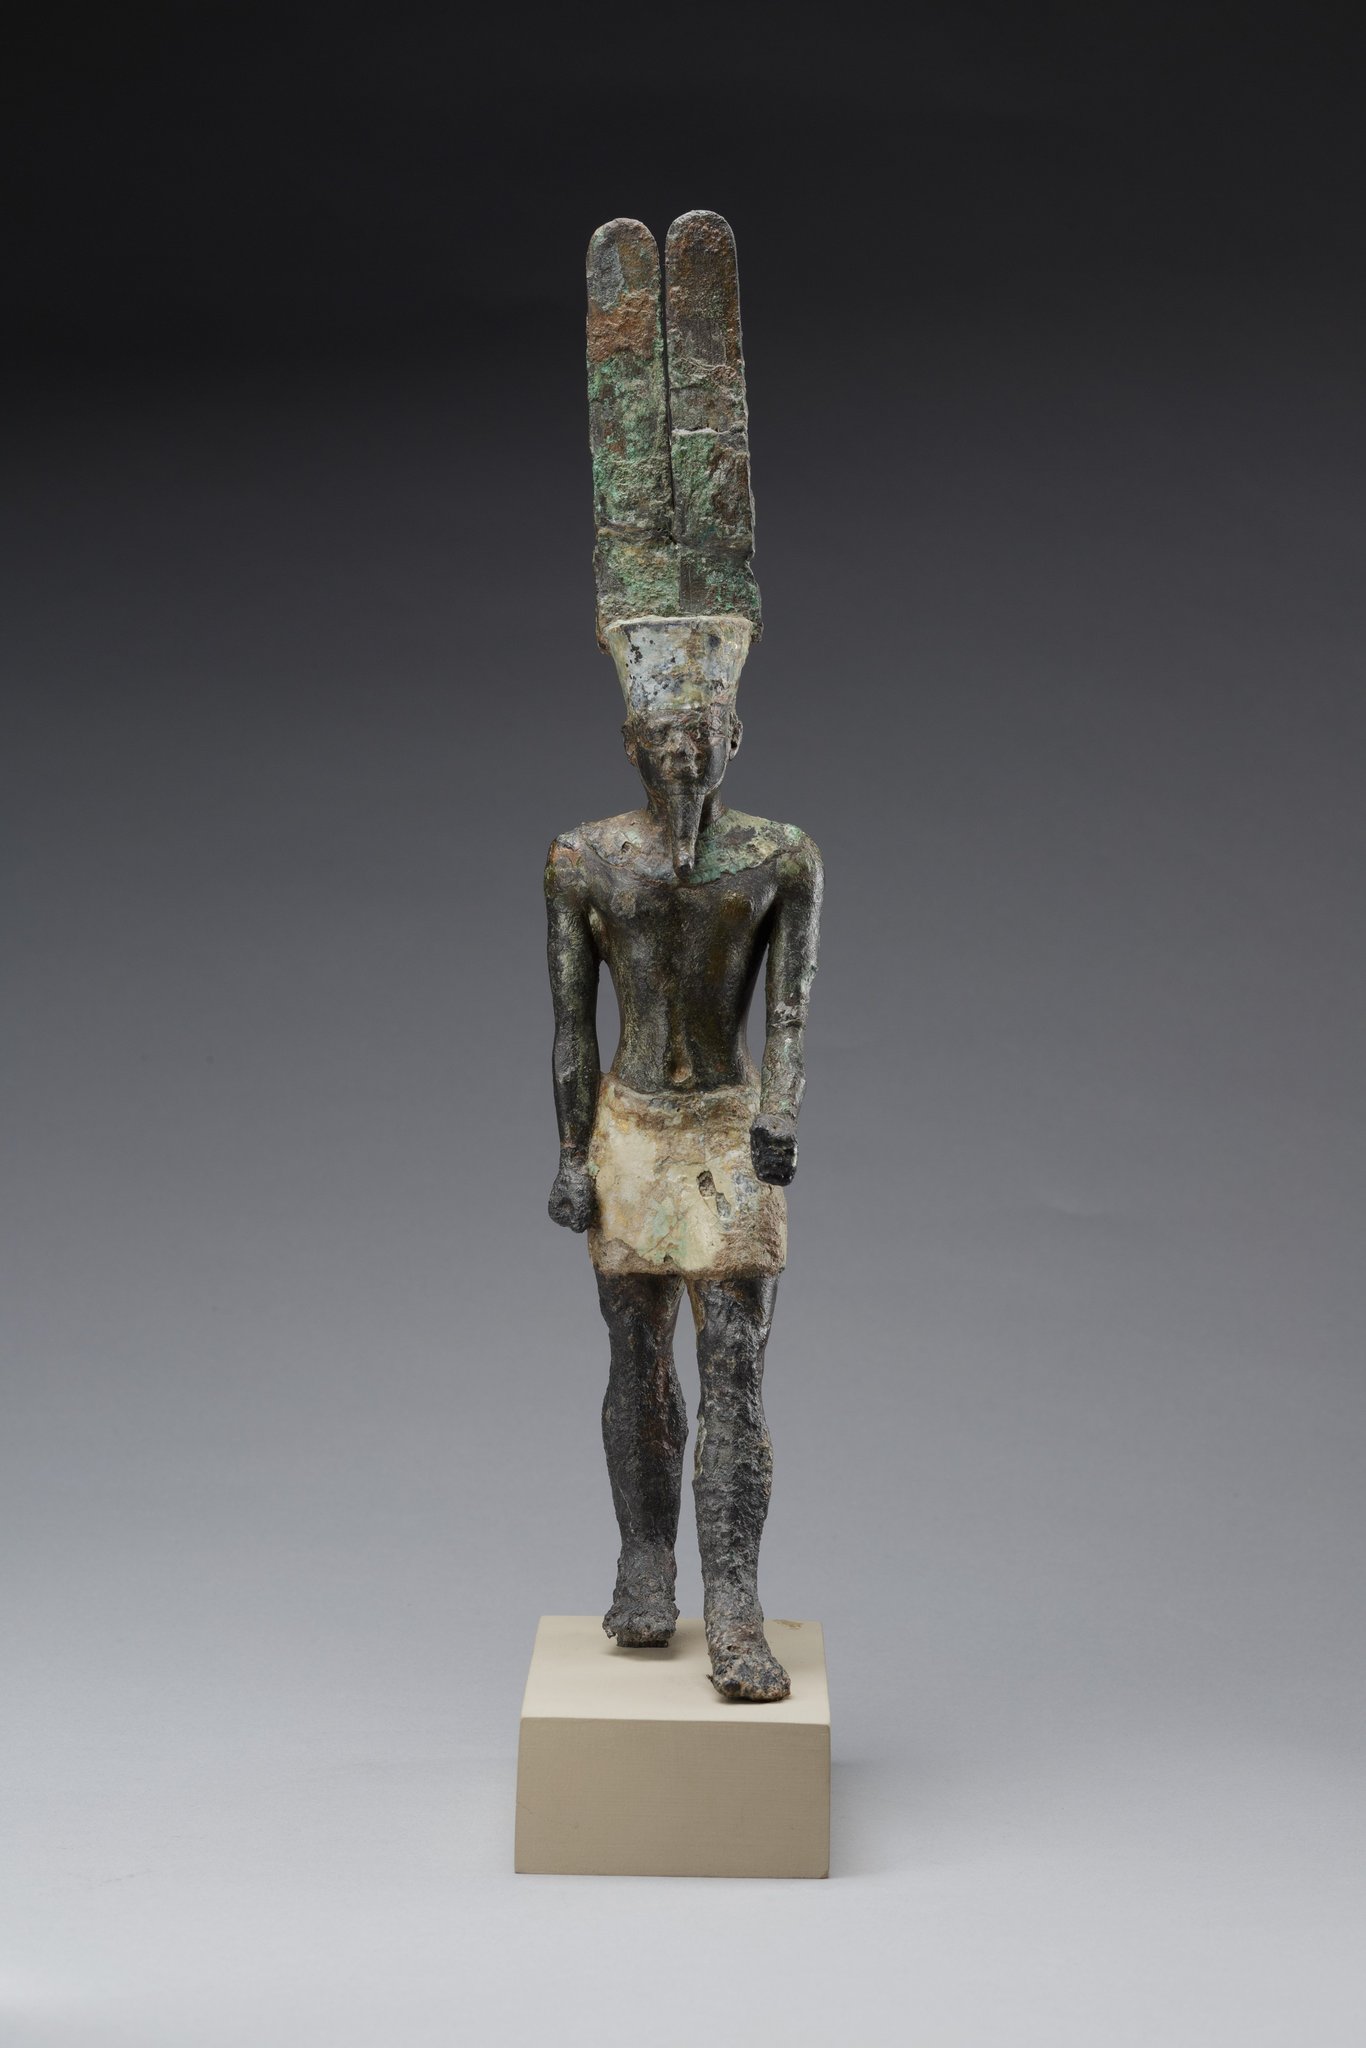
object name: statuette, amun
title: Amun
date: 750-600 BCE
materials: bronze, copper alloy, gesso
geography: egypt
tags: amun